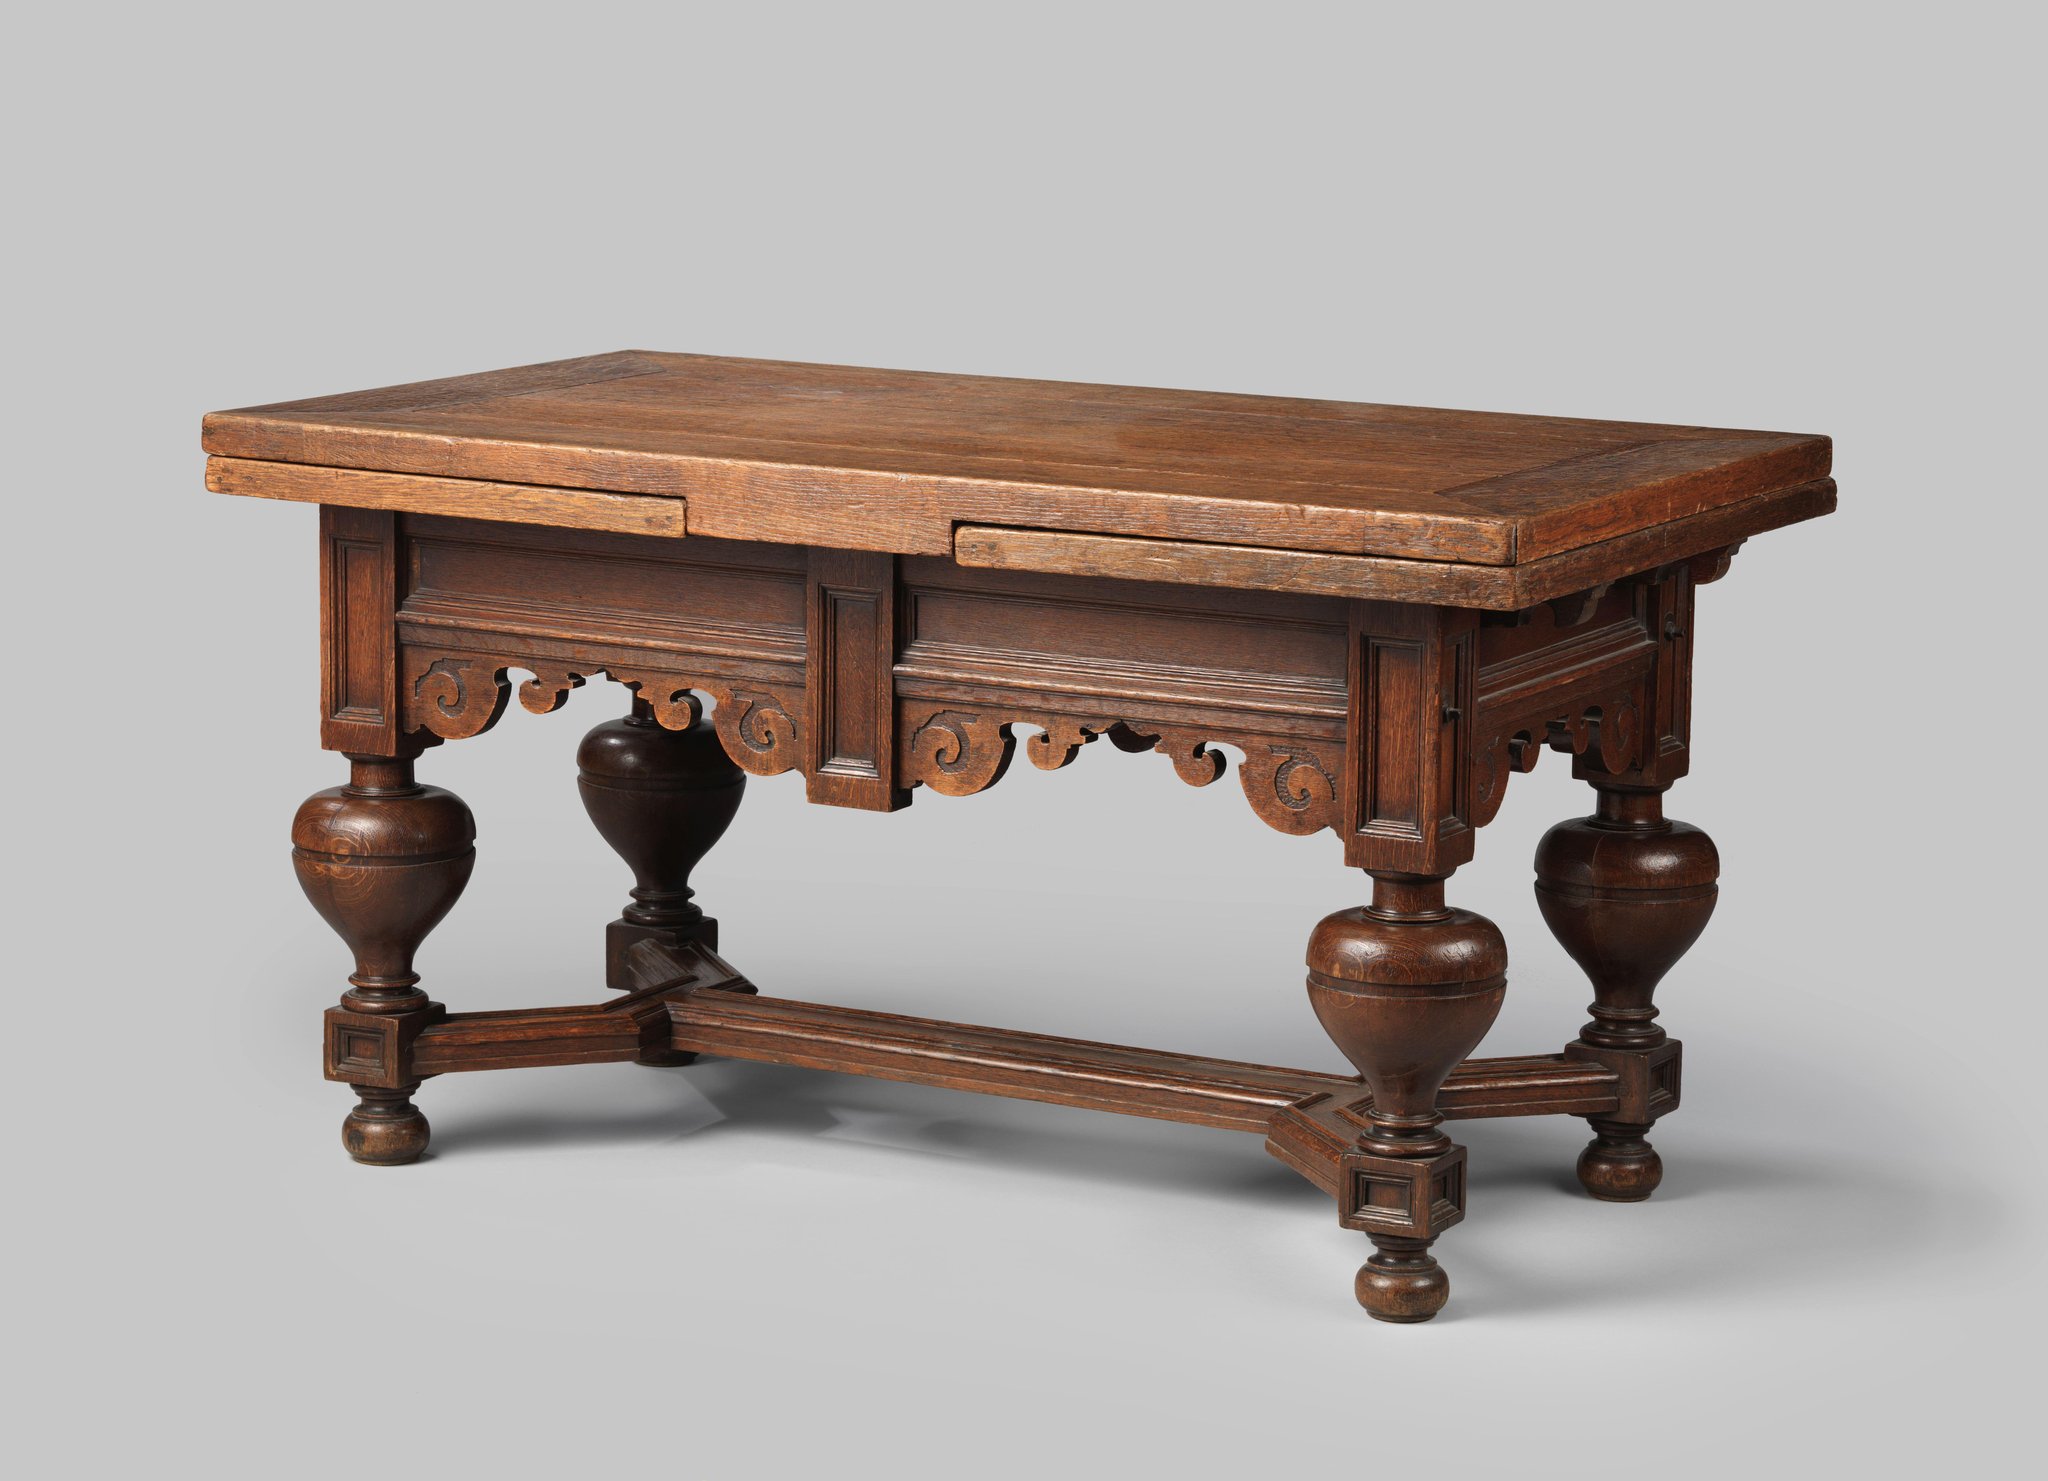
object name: draw table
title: Trektafel met dubbel Y-vormig kruis en poten die eindigen in bollen.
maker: Anonymous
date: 1600-1699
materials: wood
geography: netherlands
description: Trektafel van eikenhout met een dubbel Y-vormig kruis en poten met vaasvormige geledingen. De onderste huizen en de regels zijn in horizontale richting uitgegrond; de bovenste in verticale richting, Zij corresponderen met een verticaal geplaatst uitgegrond paneel in het midden van de voor- en achterregel. Langs de onderkant der regels loopt een uitgezaagde gegolfde rand. De poten rusten op bollen.